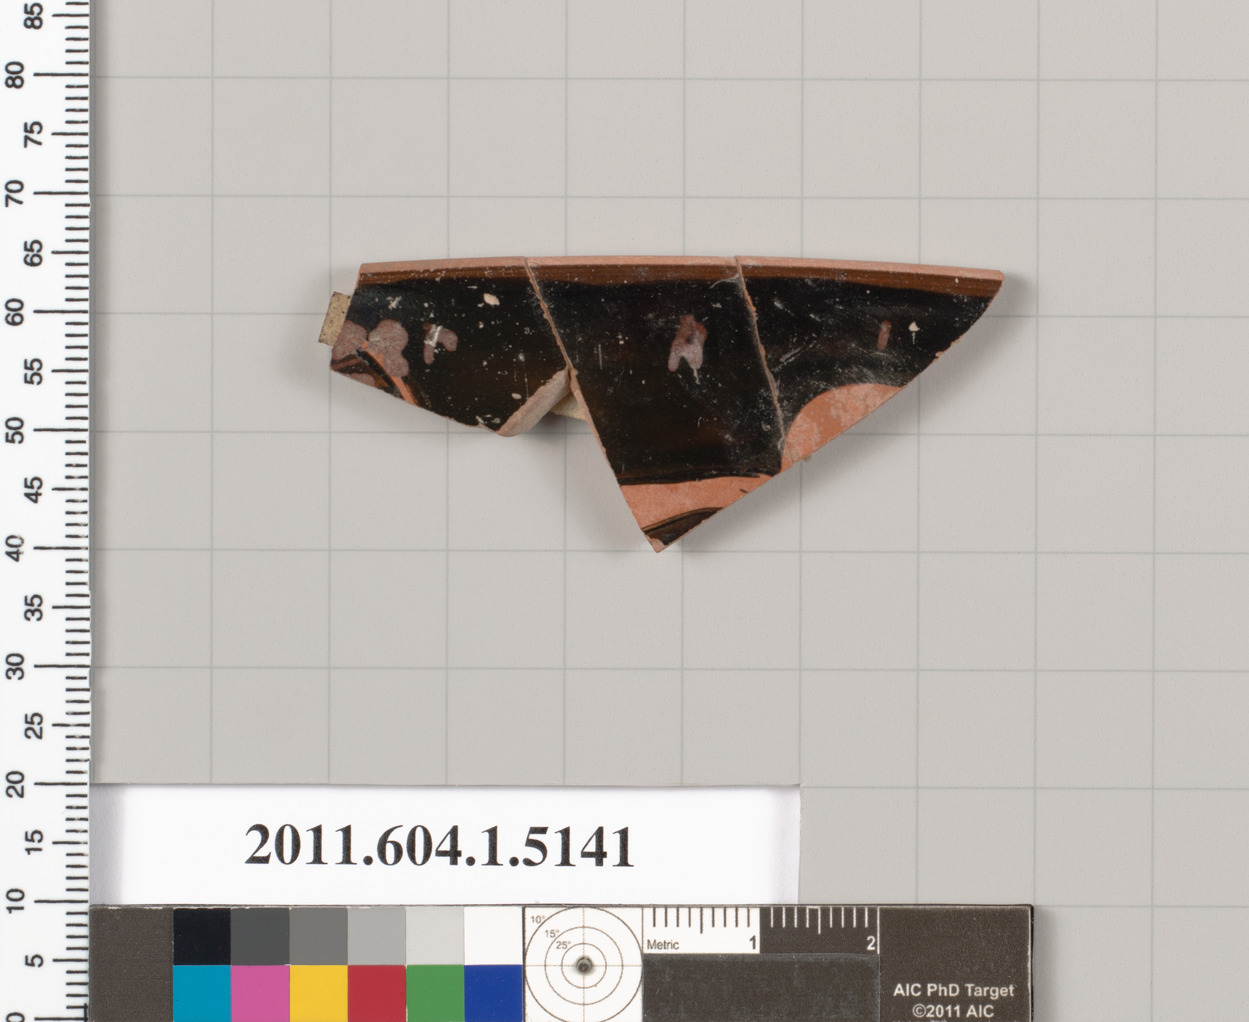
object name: kylix fragment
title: Terracotta rim fragment of a kylix (drinking cup)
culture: greek, attic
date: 510-490 BCE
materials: terracotta